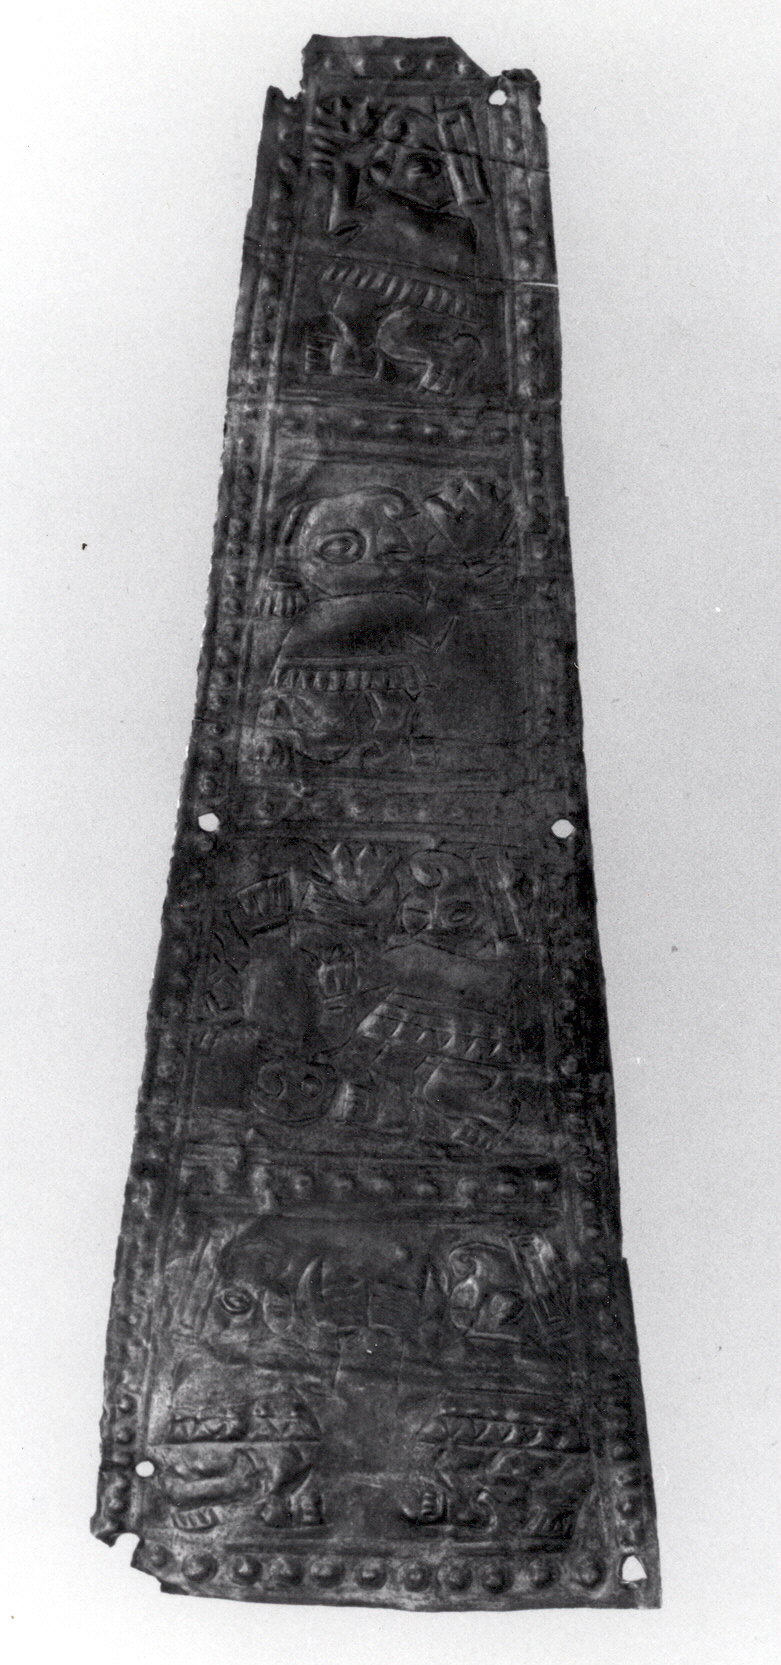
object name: sheathing fragment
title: Hammered Gold Sheathing Fragment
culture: chimú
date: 1101-1500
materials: gold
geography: peru